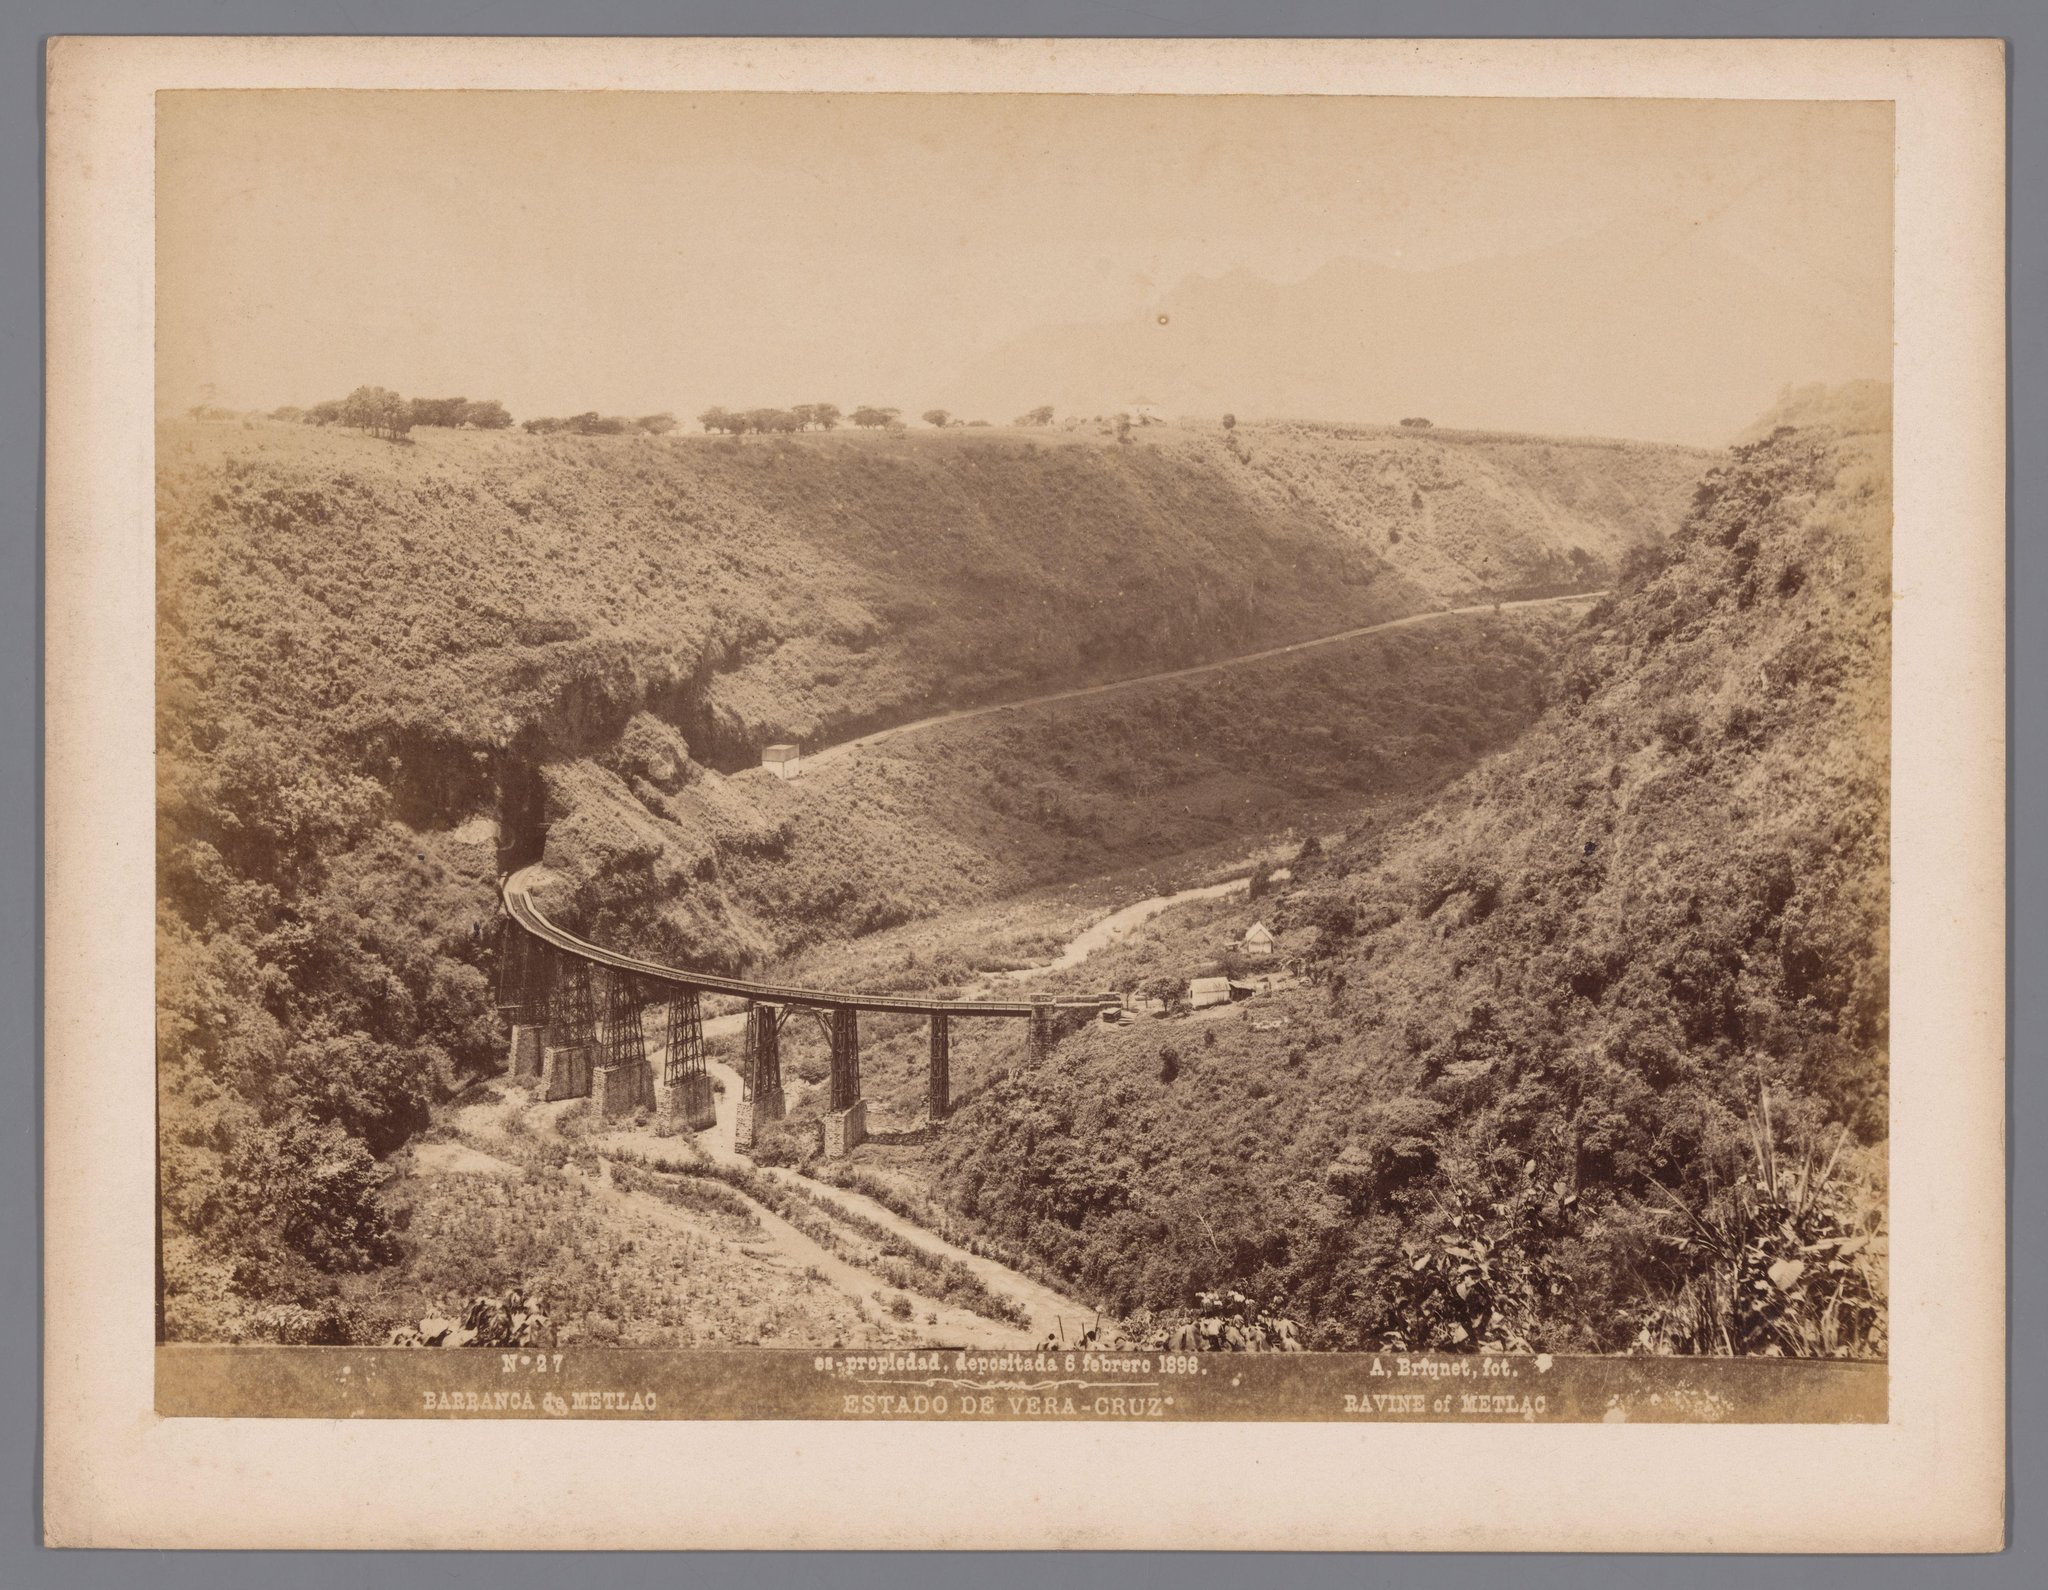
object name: photograph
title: Barranca de Metlac / Ravine of Metlac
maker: abel briquet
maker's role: fotograaf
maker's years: 1833-1926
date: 1896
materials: cardboard, paper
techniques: albumen print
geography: veracruz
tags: landscape with bridge, viaduct or aqueduct, railway, train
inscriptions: copyright notice: ‘es-propiedad, despositada 6 febrero 1896.’